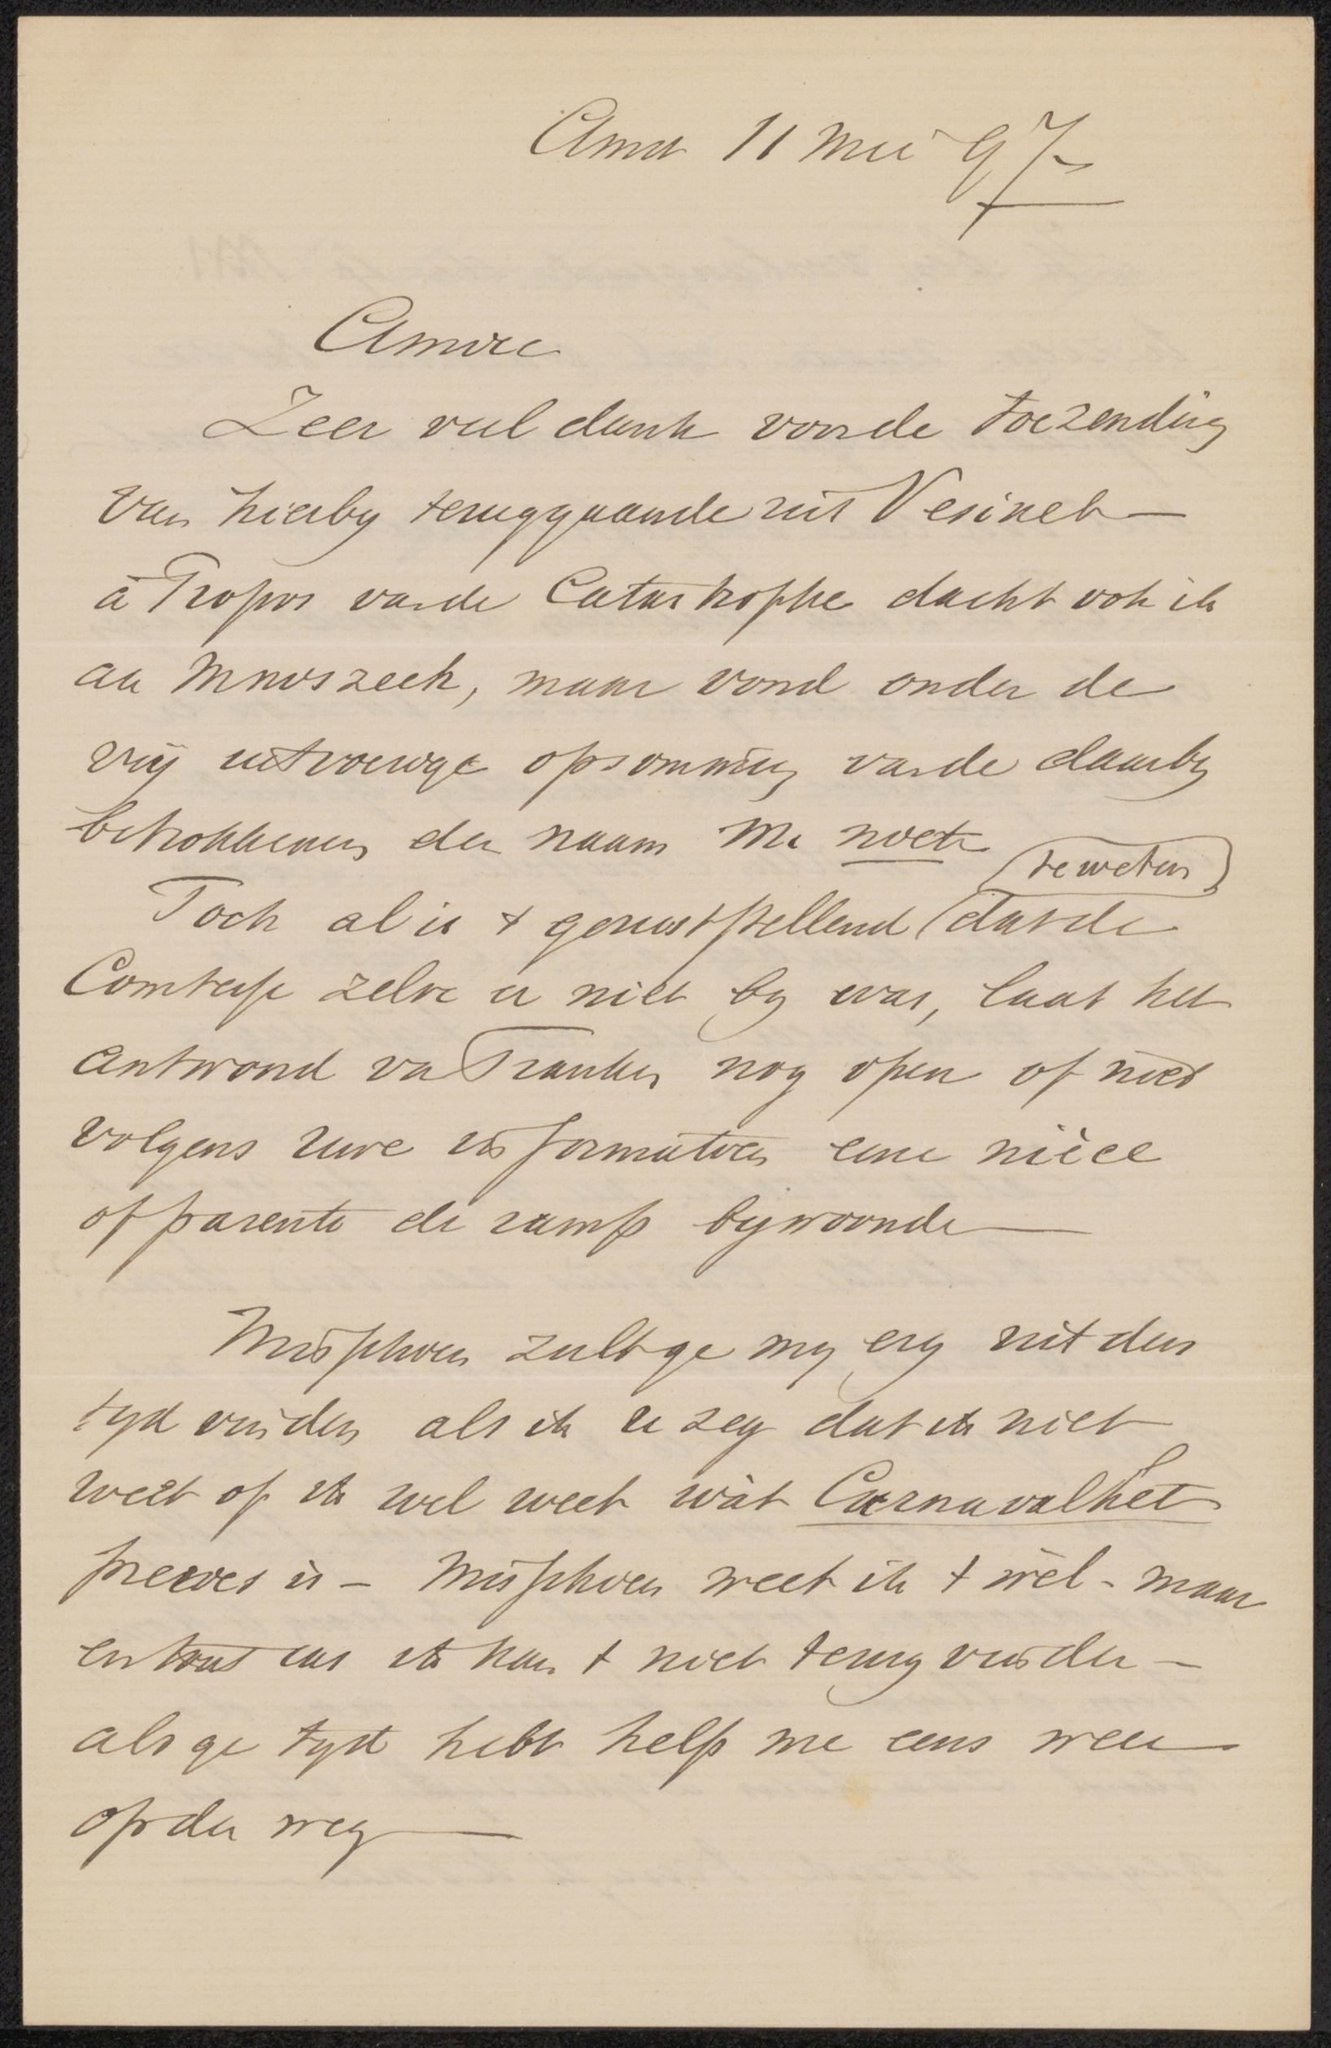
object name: letter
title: Brief aan August Allebé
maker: jan hendrik maschaupt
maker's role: painter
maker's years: 1826-1903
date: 1897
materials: ink, paper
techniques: pen, writing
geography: amsterdam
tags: paris, painter, andrzej graaf mniszech, amsterdam, print maker, draughtsman, august allebé, daniël franken dzn.